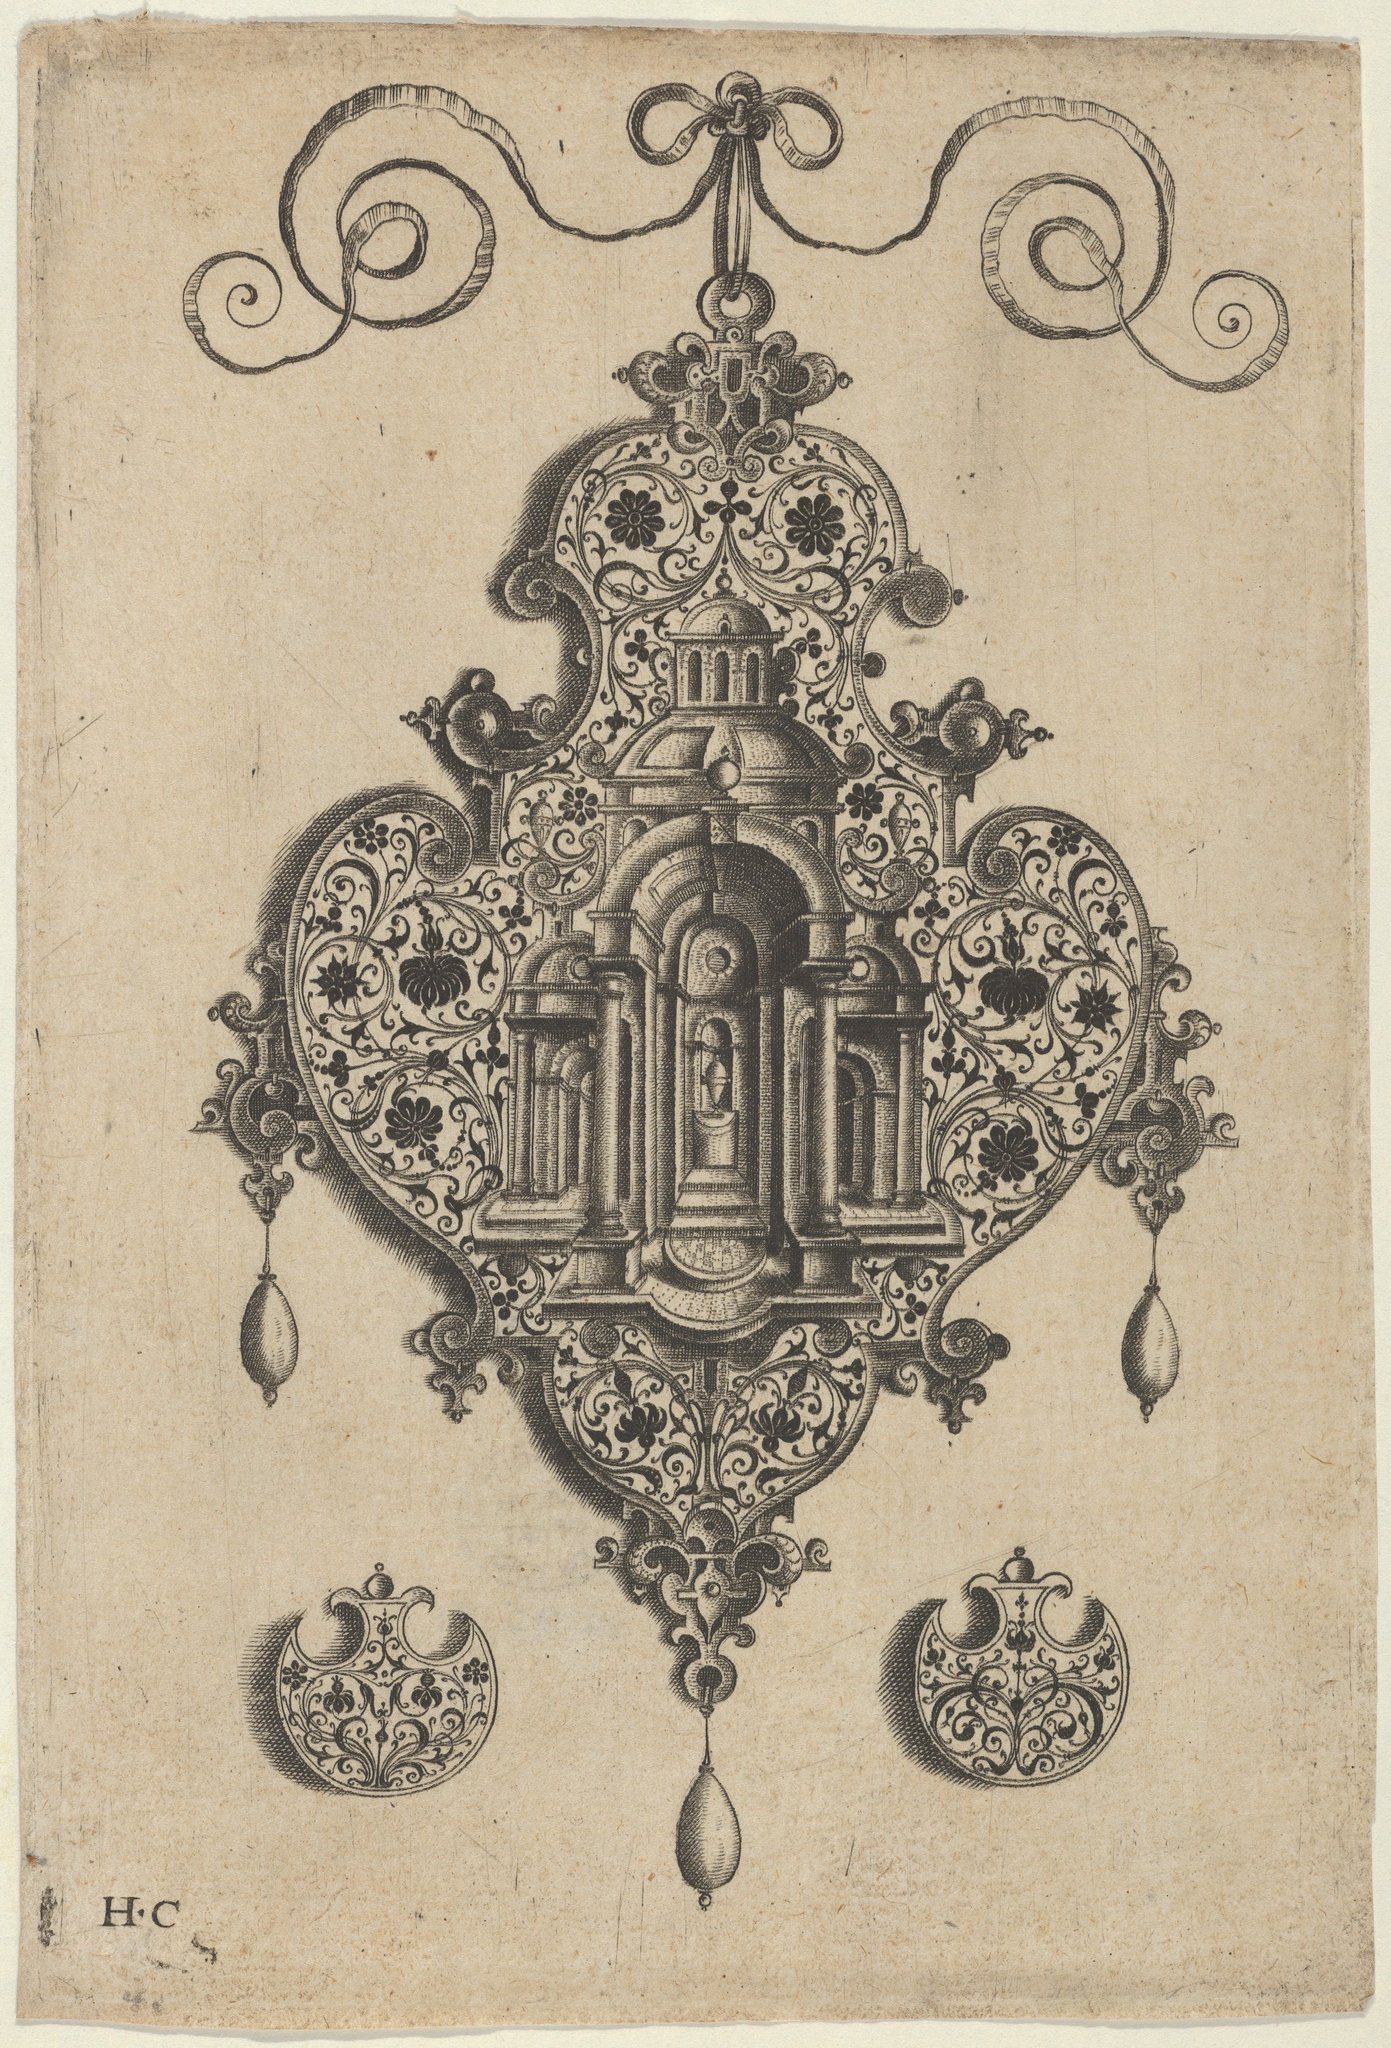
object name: print ornament architecture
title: Pendant Design with a Domed Church and Urn Above Axe-Shaped Ornaments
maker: jan collaert i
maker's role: artist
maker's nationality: netherlandish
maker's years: 1530-1581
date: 1573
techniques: embroidery, engraving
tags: churches,pendants